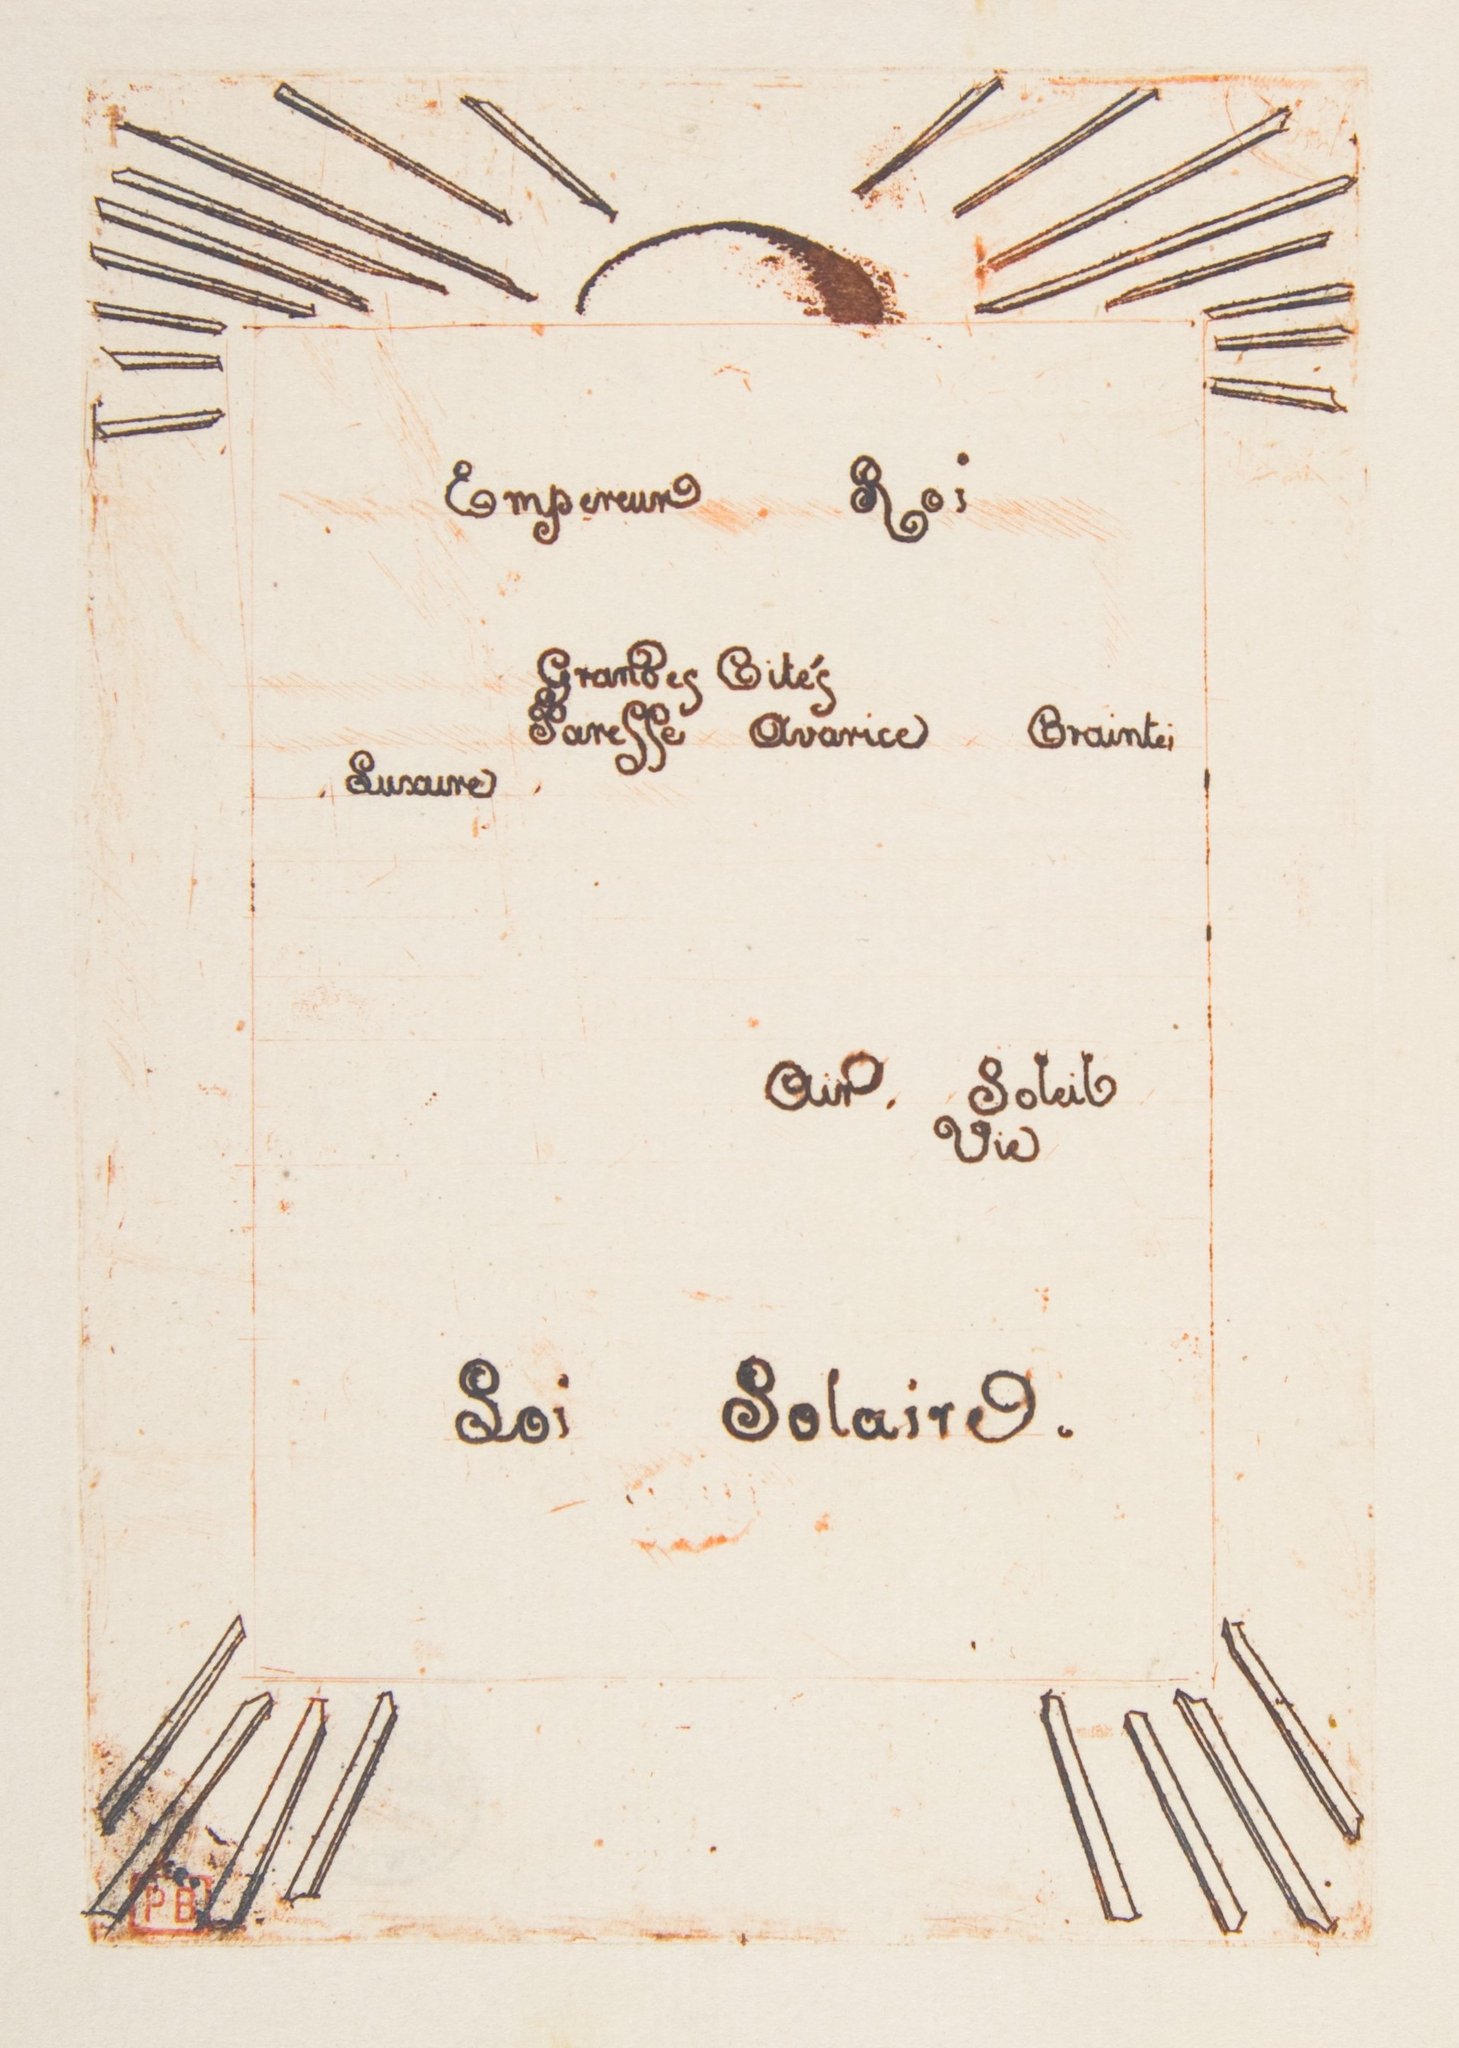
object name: print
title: La Loi Solaire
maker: charles meryon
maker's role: artist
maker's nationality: french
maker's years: 1821-1868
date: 1801-1900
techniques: etching